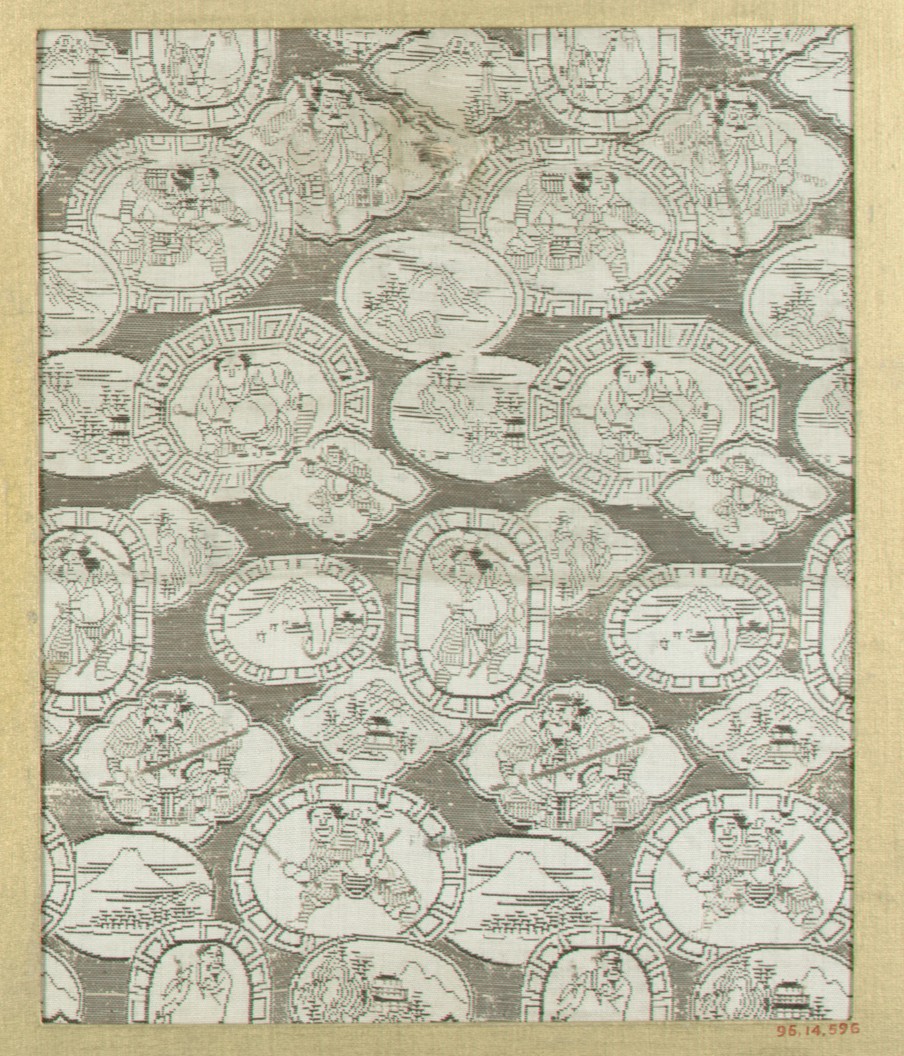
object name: piece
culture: japanese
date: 1701-1900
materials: silk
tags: men